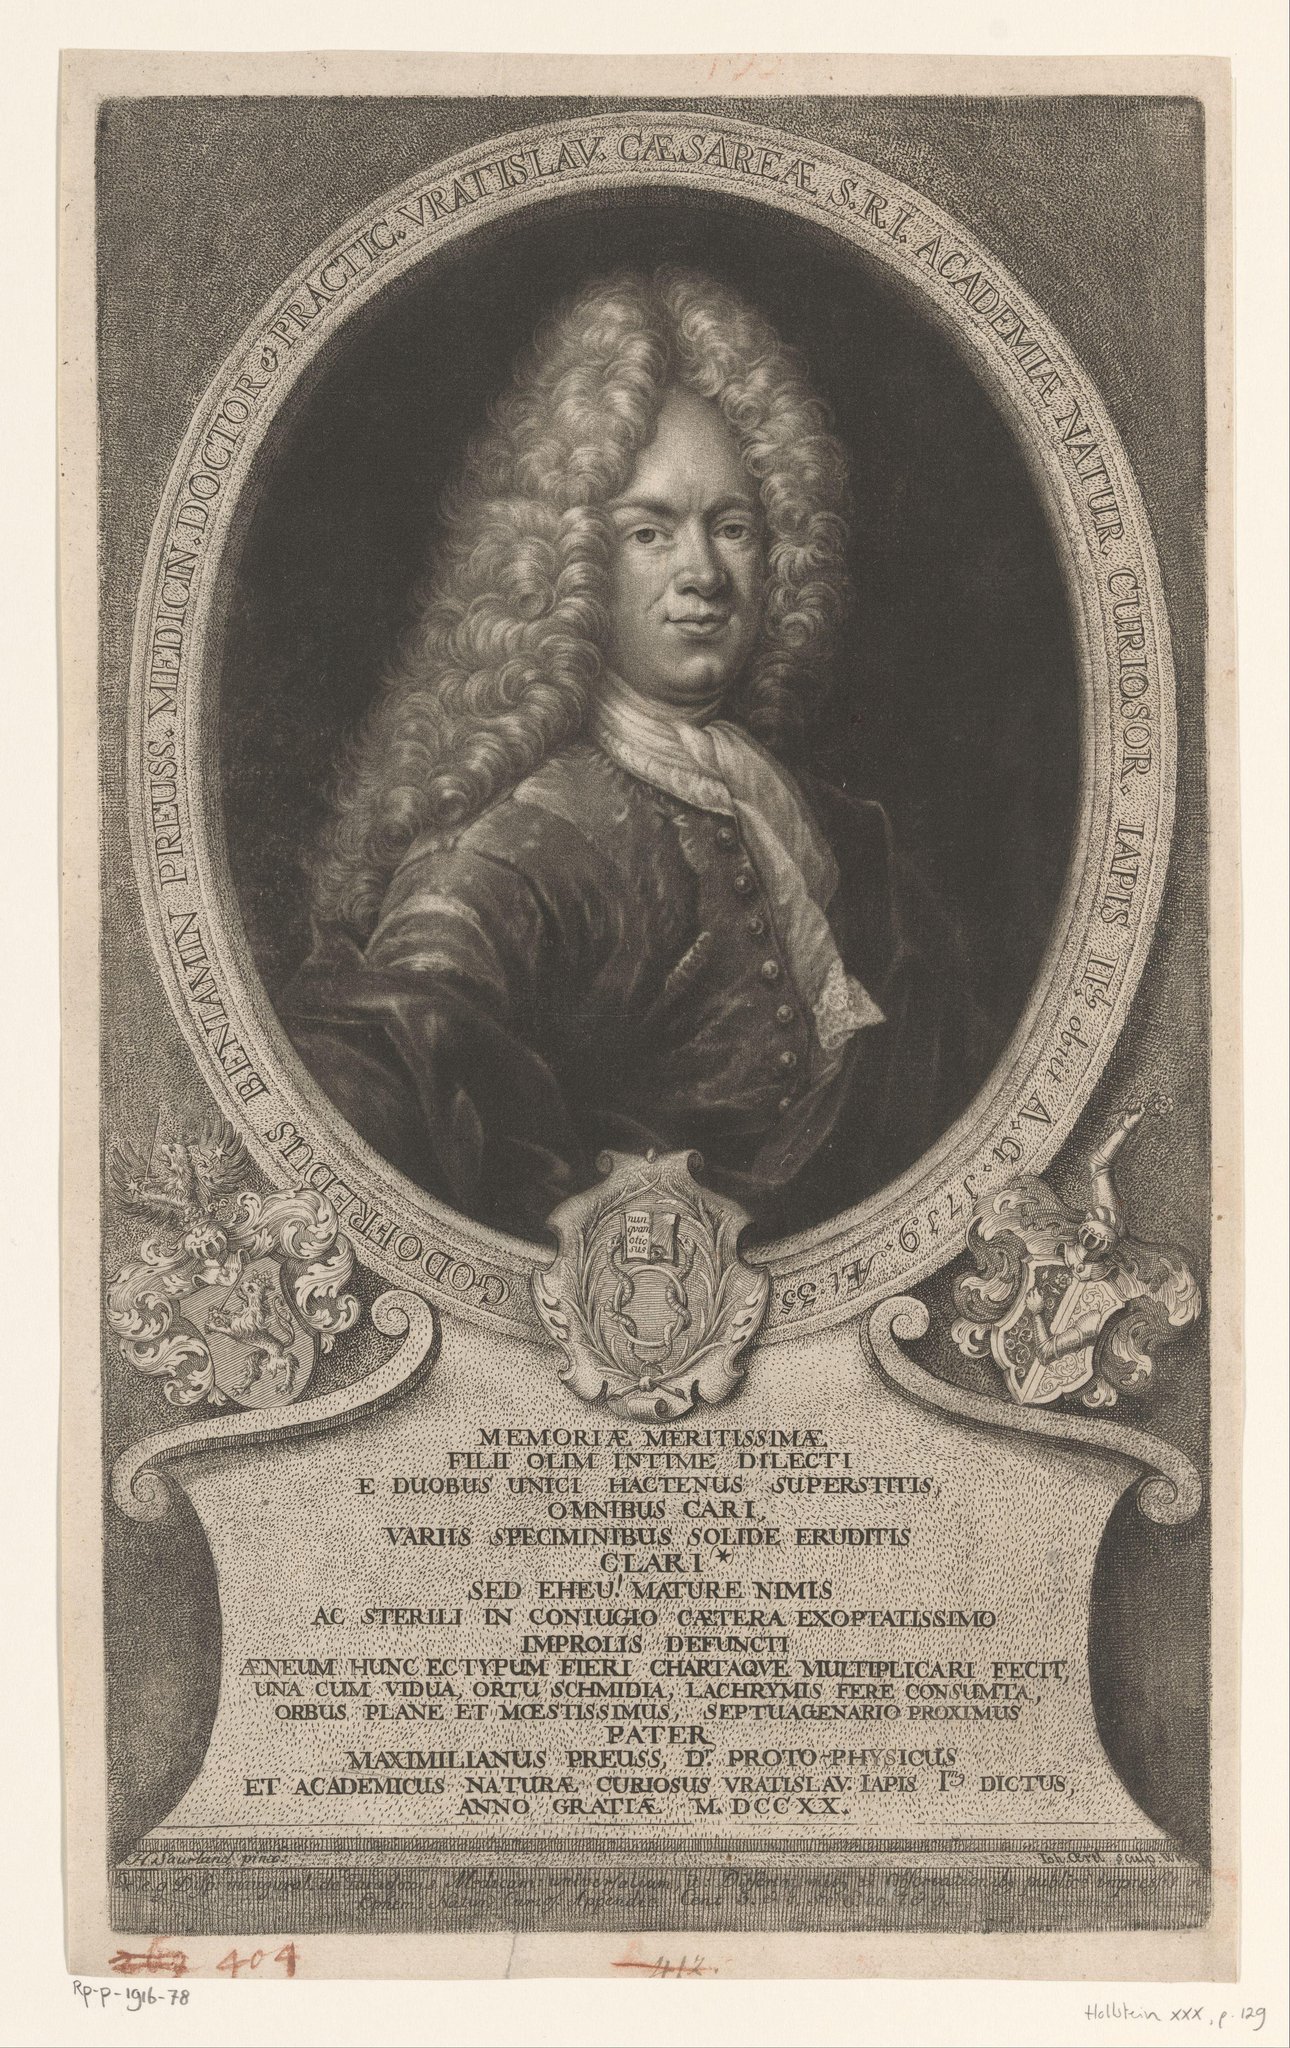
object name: print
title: Portret van Gottfried Benjamin Preuss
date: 1720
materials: paper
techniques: etching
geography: wroclaw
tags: gottfried benjamin preuss, historical persons, abstract ideas and concepts (+ emblematical representation of concept), armorial bearing, heraldry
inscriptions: collector's mark: Lugt 2228